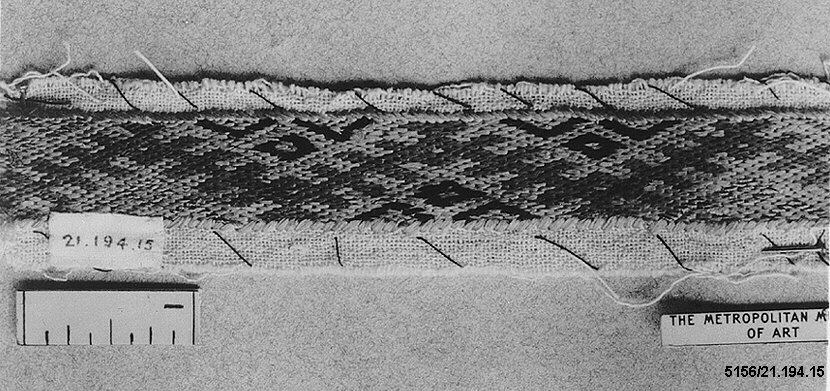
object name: fragment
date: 1801-1900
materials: silk